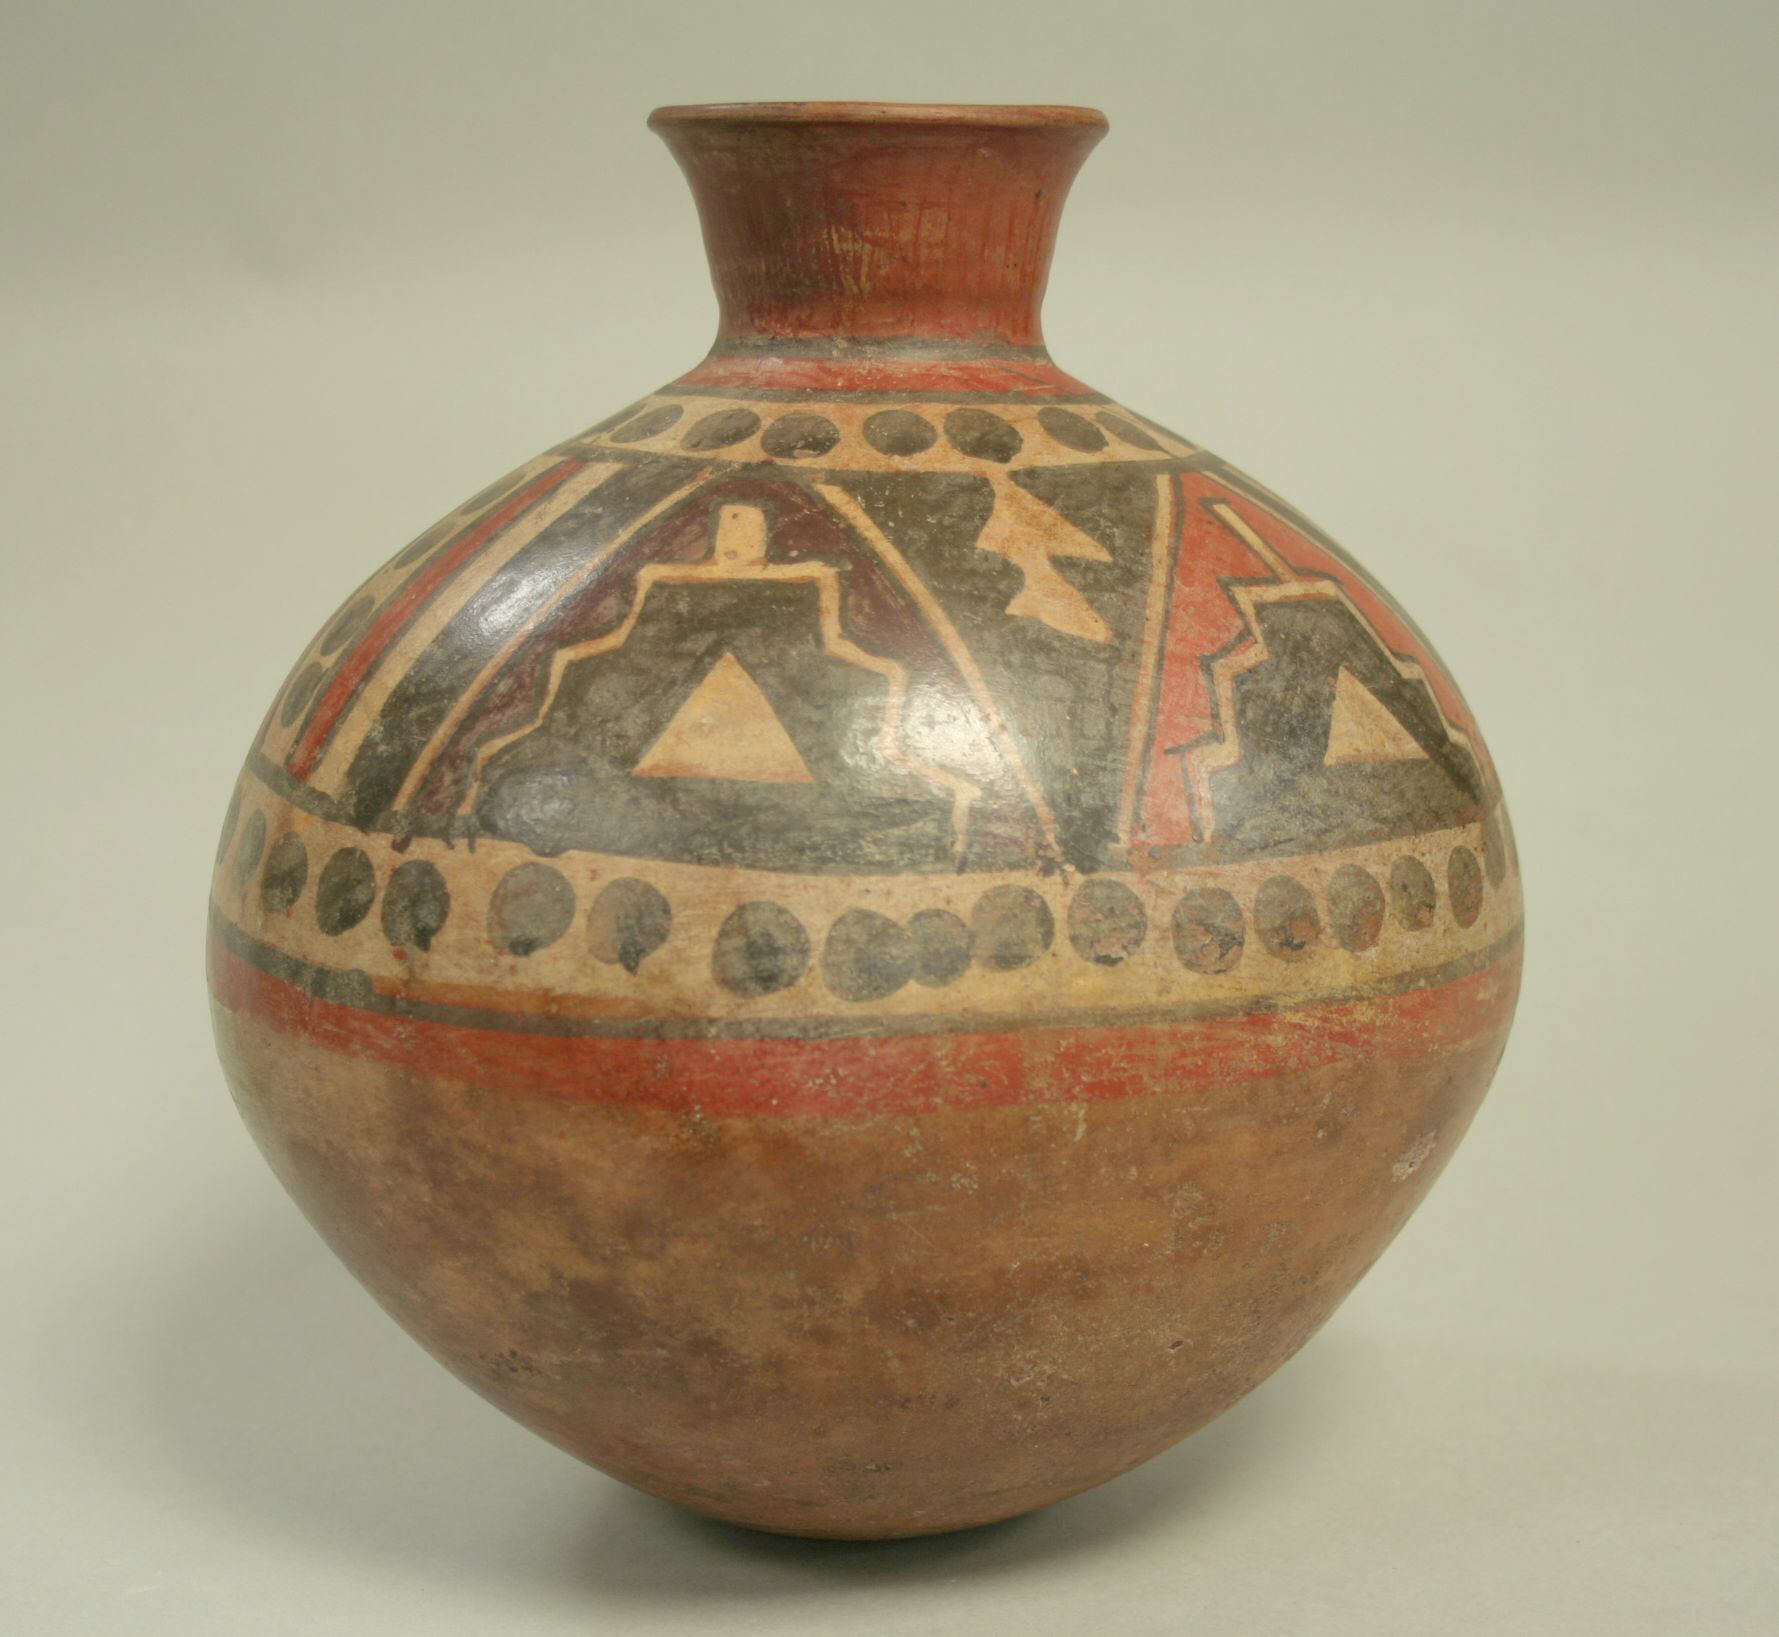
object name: bottle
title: Painted Single Spout Bottle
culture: peruvian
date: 1401-1600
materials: ceramic, pigment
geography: peru